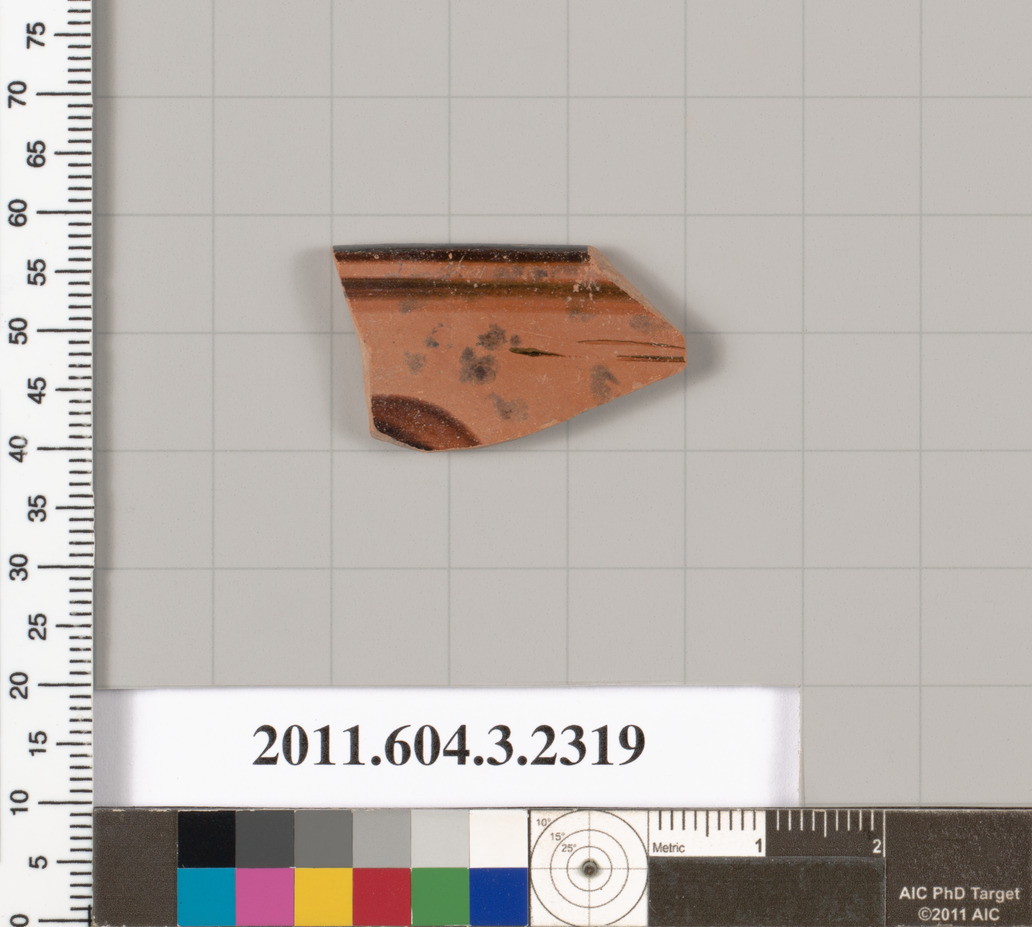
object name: kylix fragment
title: Terracotta rim fragment of a kylix: eye-cup (drinking cup)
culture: greek, attic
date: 530-500 BCE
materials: terracotta